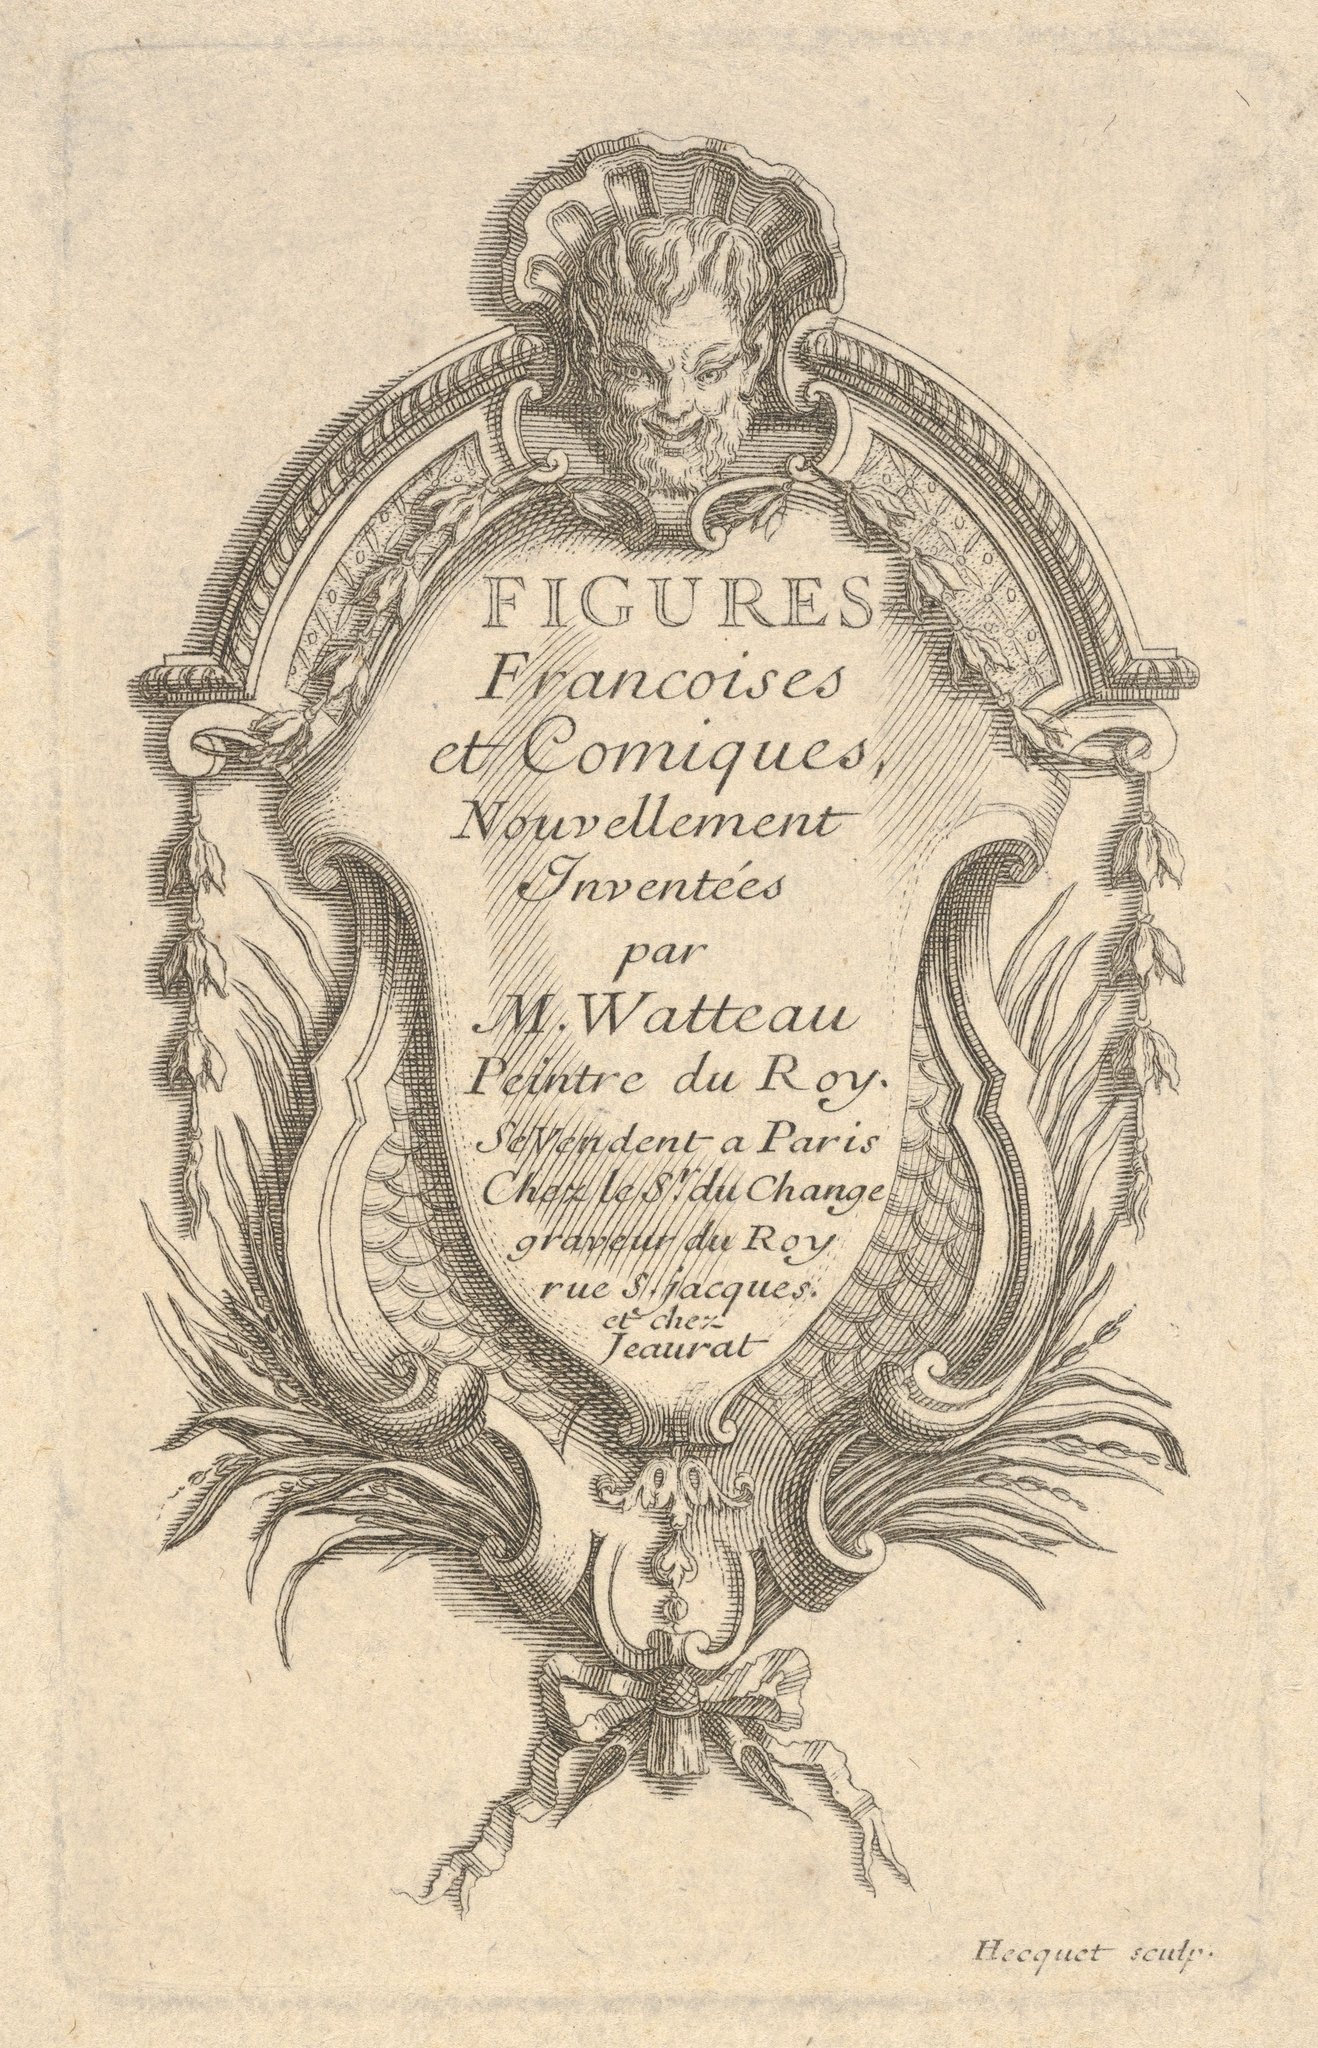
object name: print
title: Frontispiece for "Figures French and comic" (Figures francoises et comiques)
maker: robert hecquet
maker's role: artist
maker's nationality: french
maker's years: 1693-1775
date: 1684-1721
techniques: engraving, etching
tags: faces,leaves